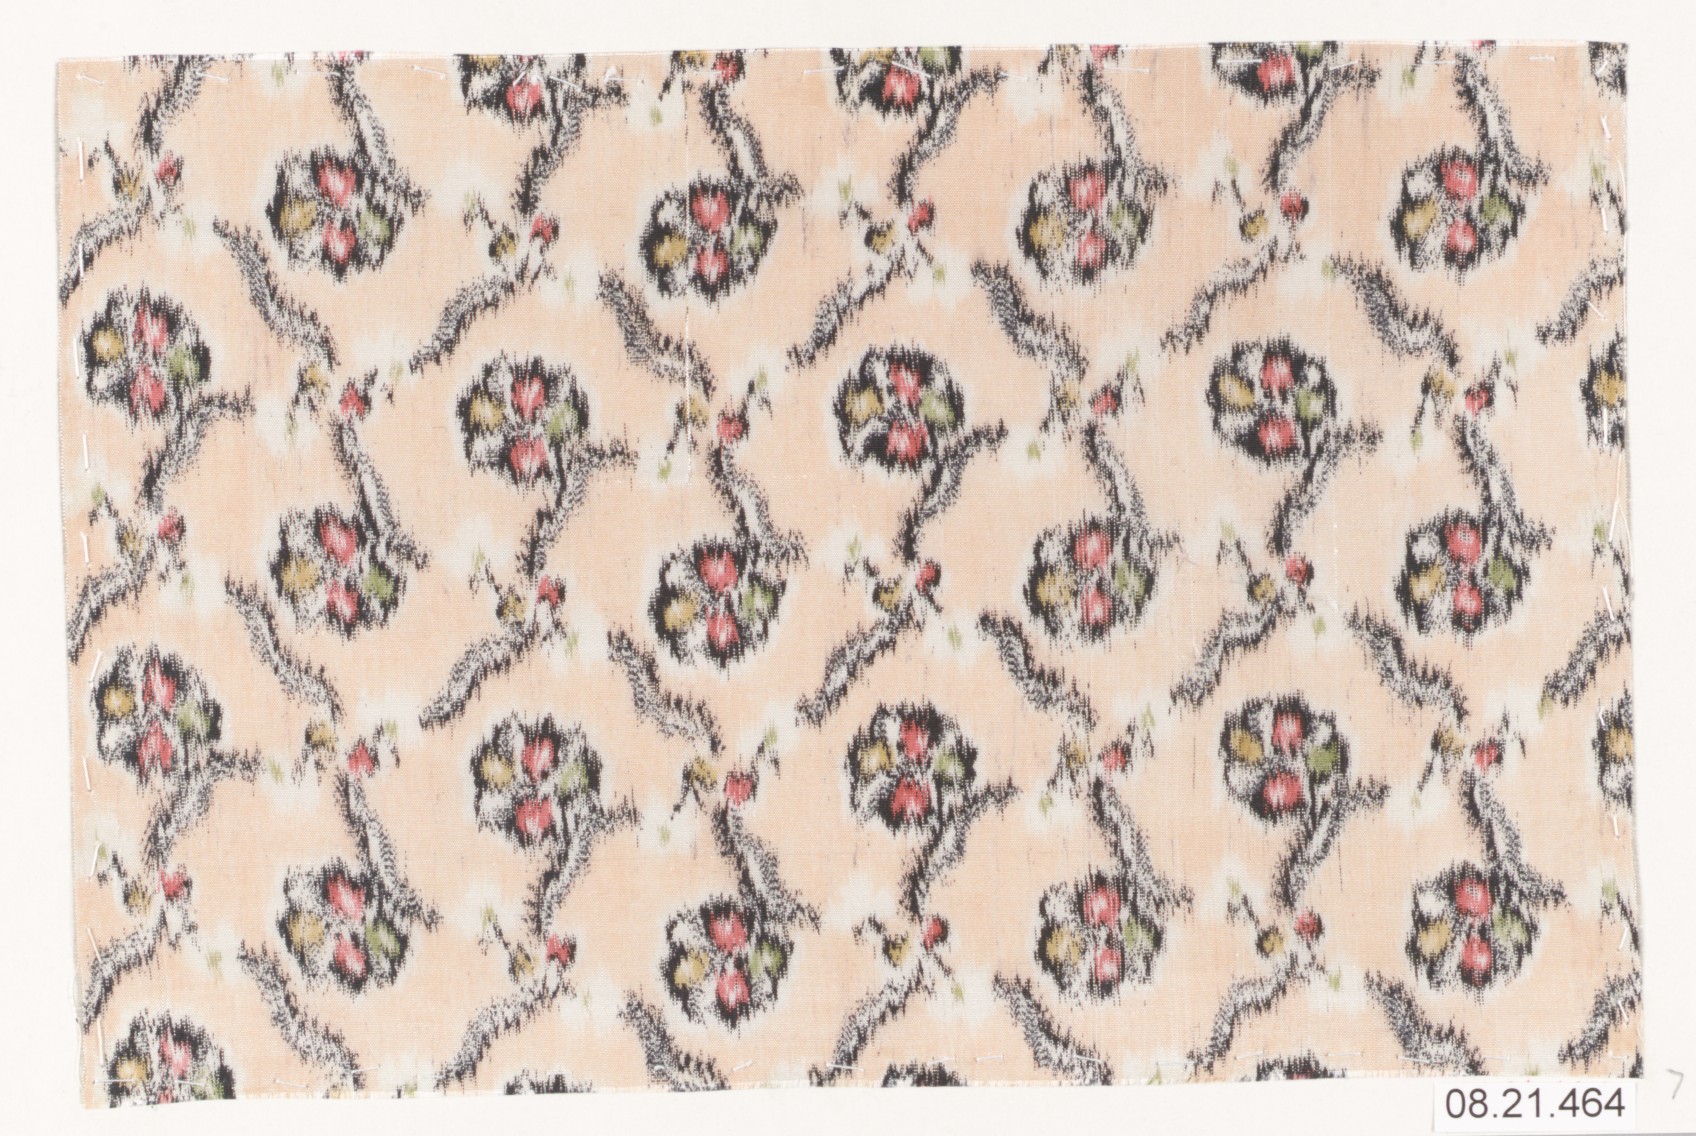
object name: textile sample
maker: Anonymous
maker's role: designer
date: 1900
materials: silk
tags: flowers